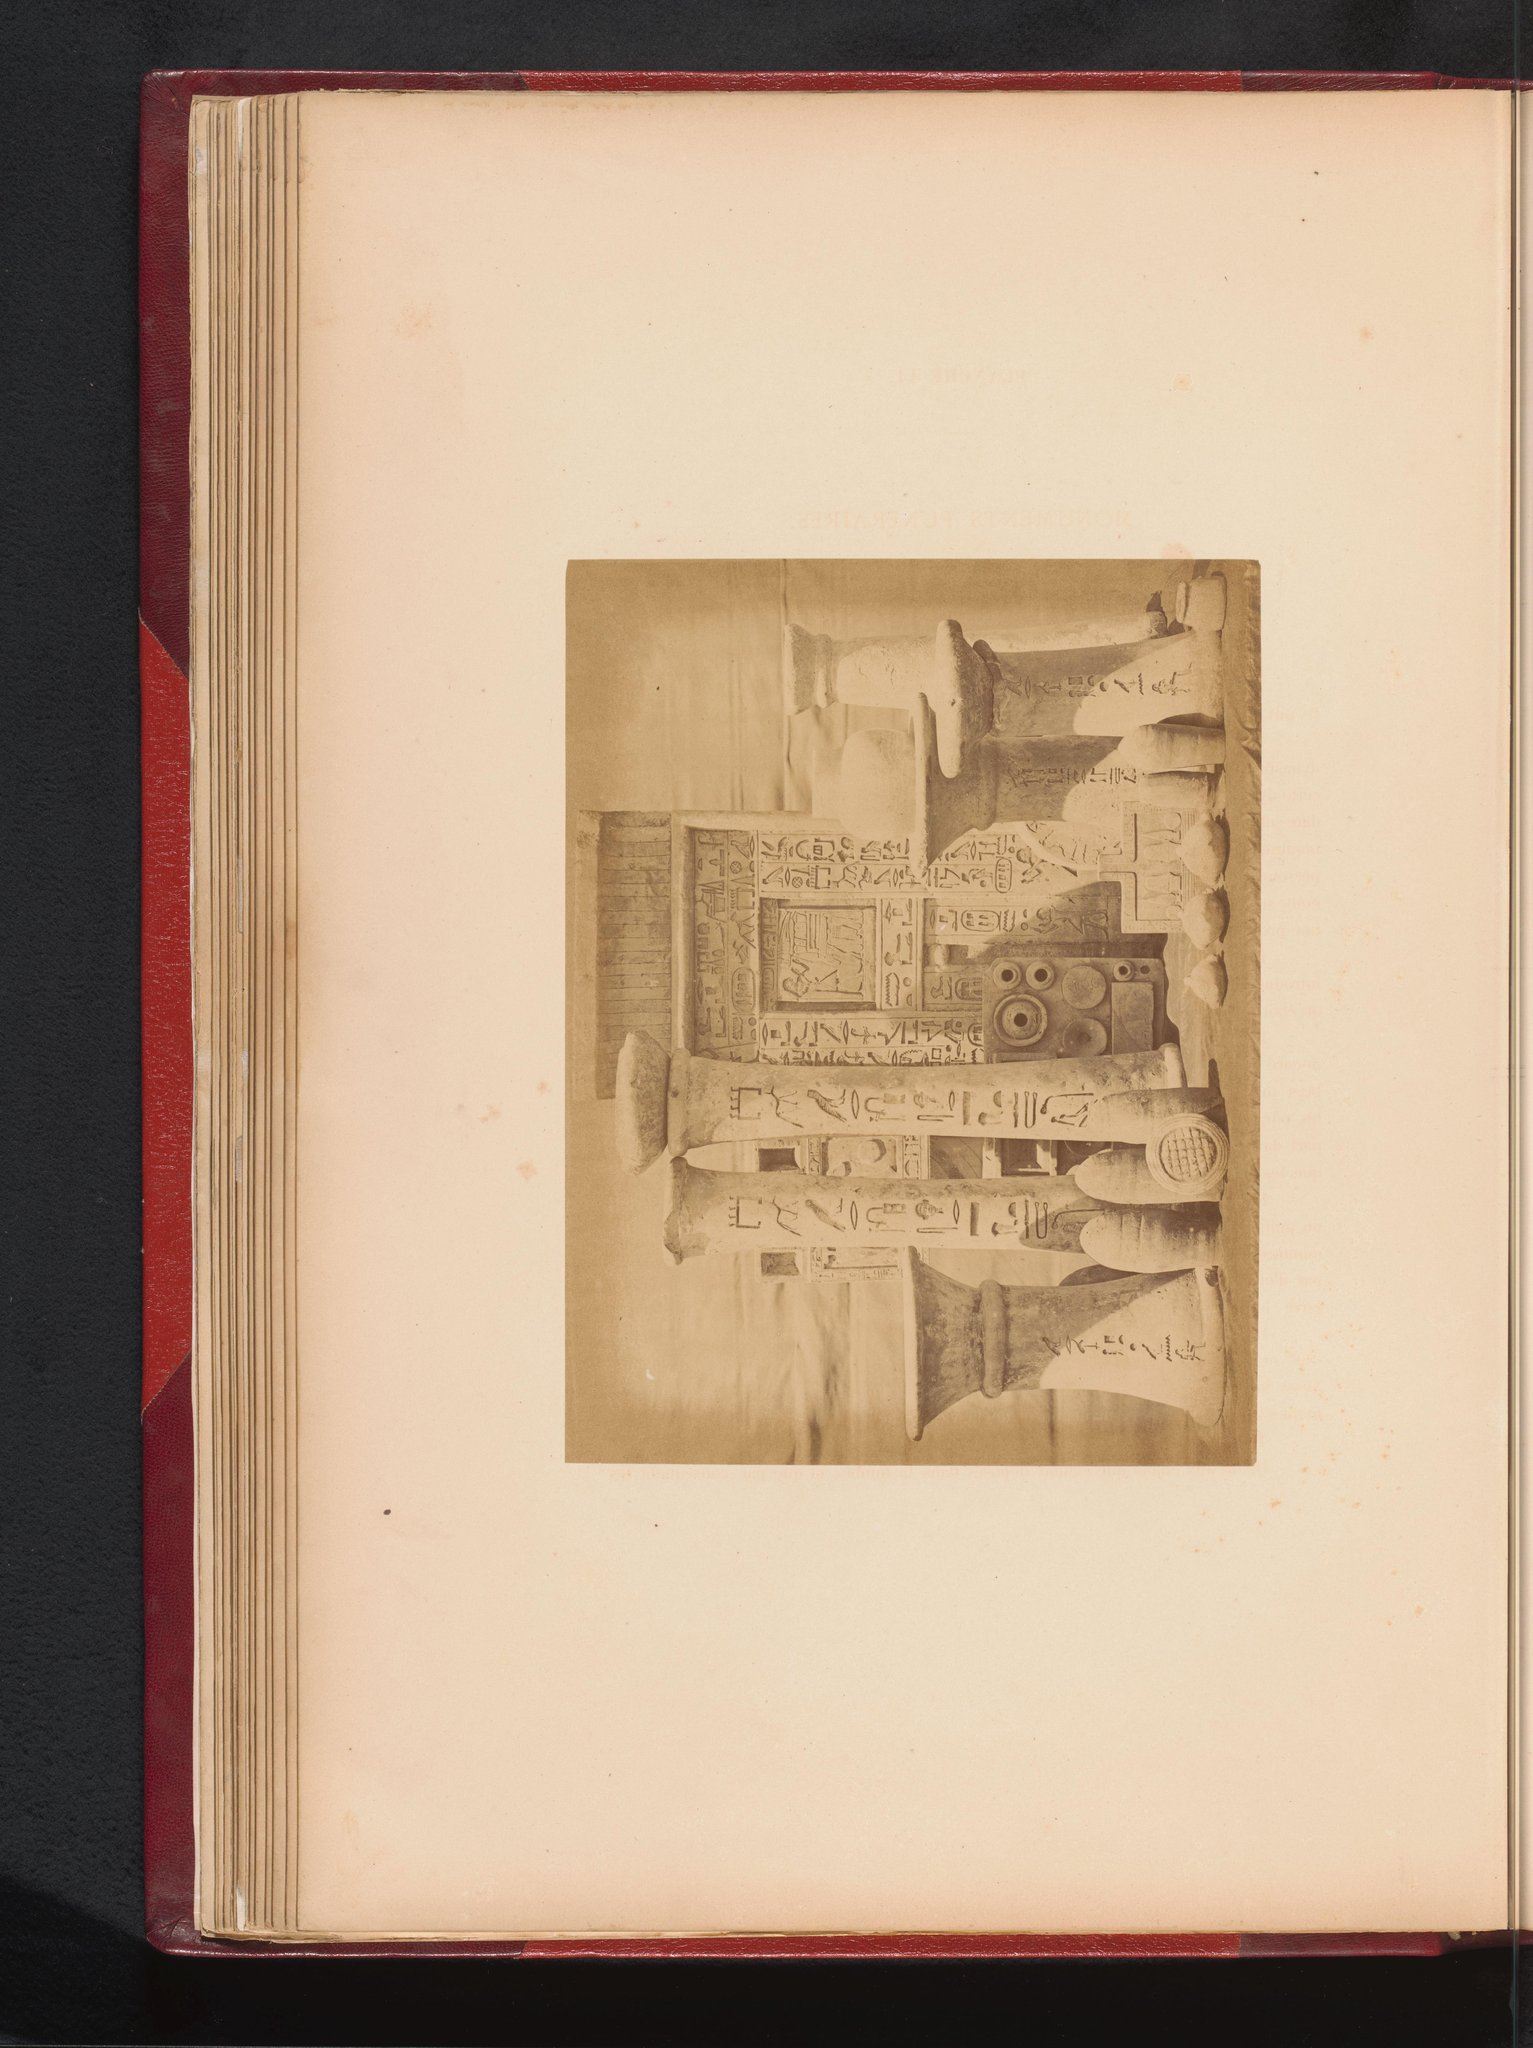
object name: page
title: Grafmonumenten in het Boulaq Museum in Caïro, Egypte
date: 1866-1871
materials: photographic support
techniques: albumen print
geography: cairo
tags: permanent exhibition, museum, other memorial structures